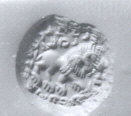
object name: stamp seal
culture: sasanian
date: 401-700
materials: gemstone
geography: iran